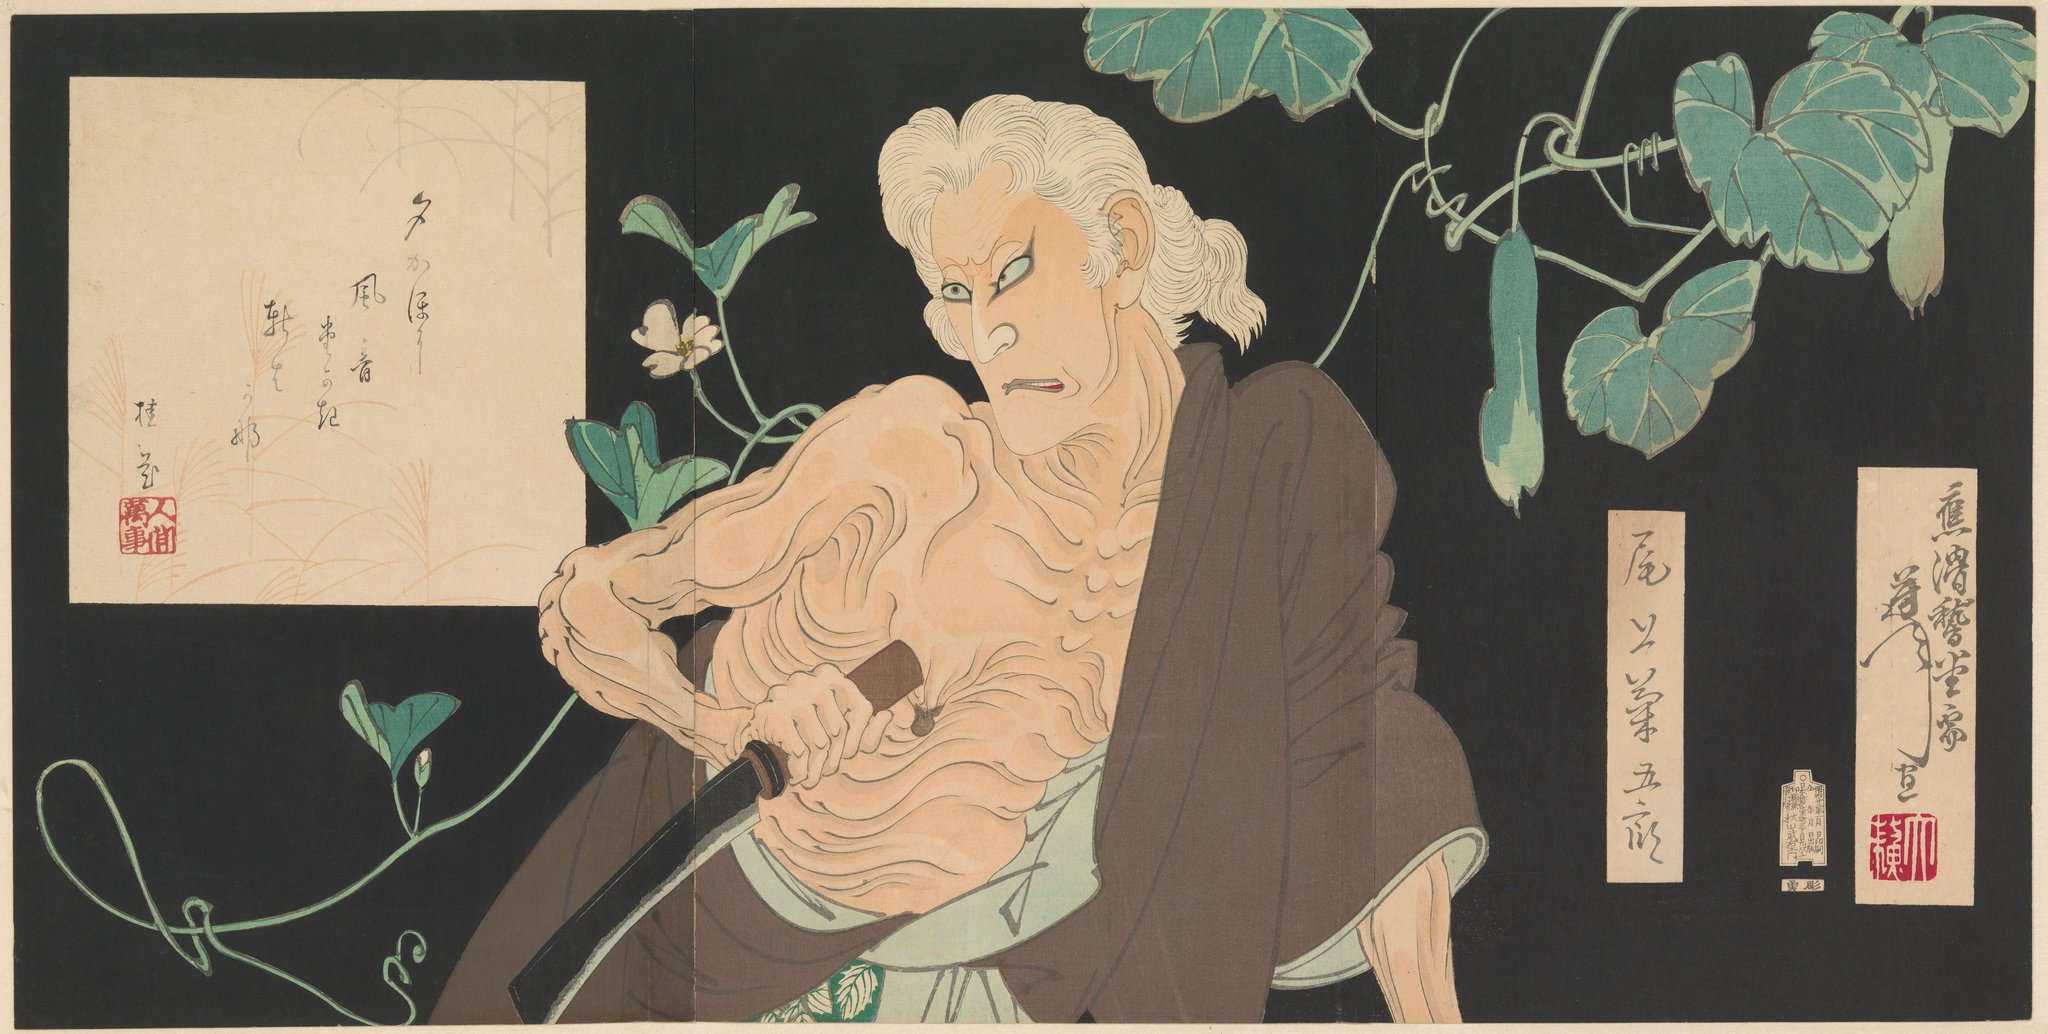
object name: print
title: The Lonely House on Adachi Moor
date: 1801-1890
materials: paper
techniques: woodcut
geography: japan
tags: plants; vegetation, old woman, tools, aids, implements ~ crafts and industries: knife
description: Many Kabuki perfomances are based on old folktales. These can be historical of fictitious events, or a combination of the two. The latter could be the case with the horror play of The Lonely House on Adachi Moor. Leading man Onoe Kikugoro V is depicted here in his role as a murderous old witch, who killed unsuspecting travellers.